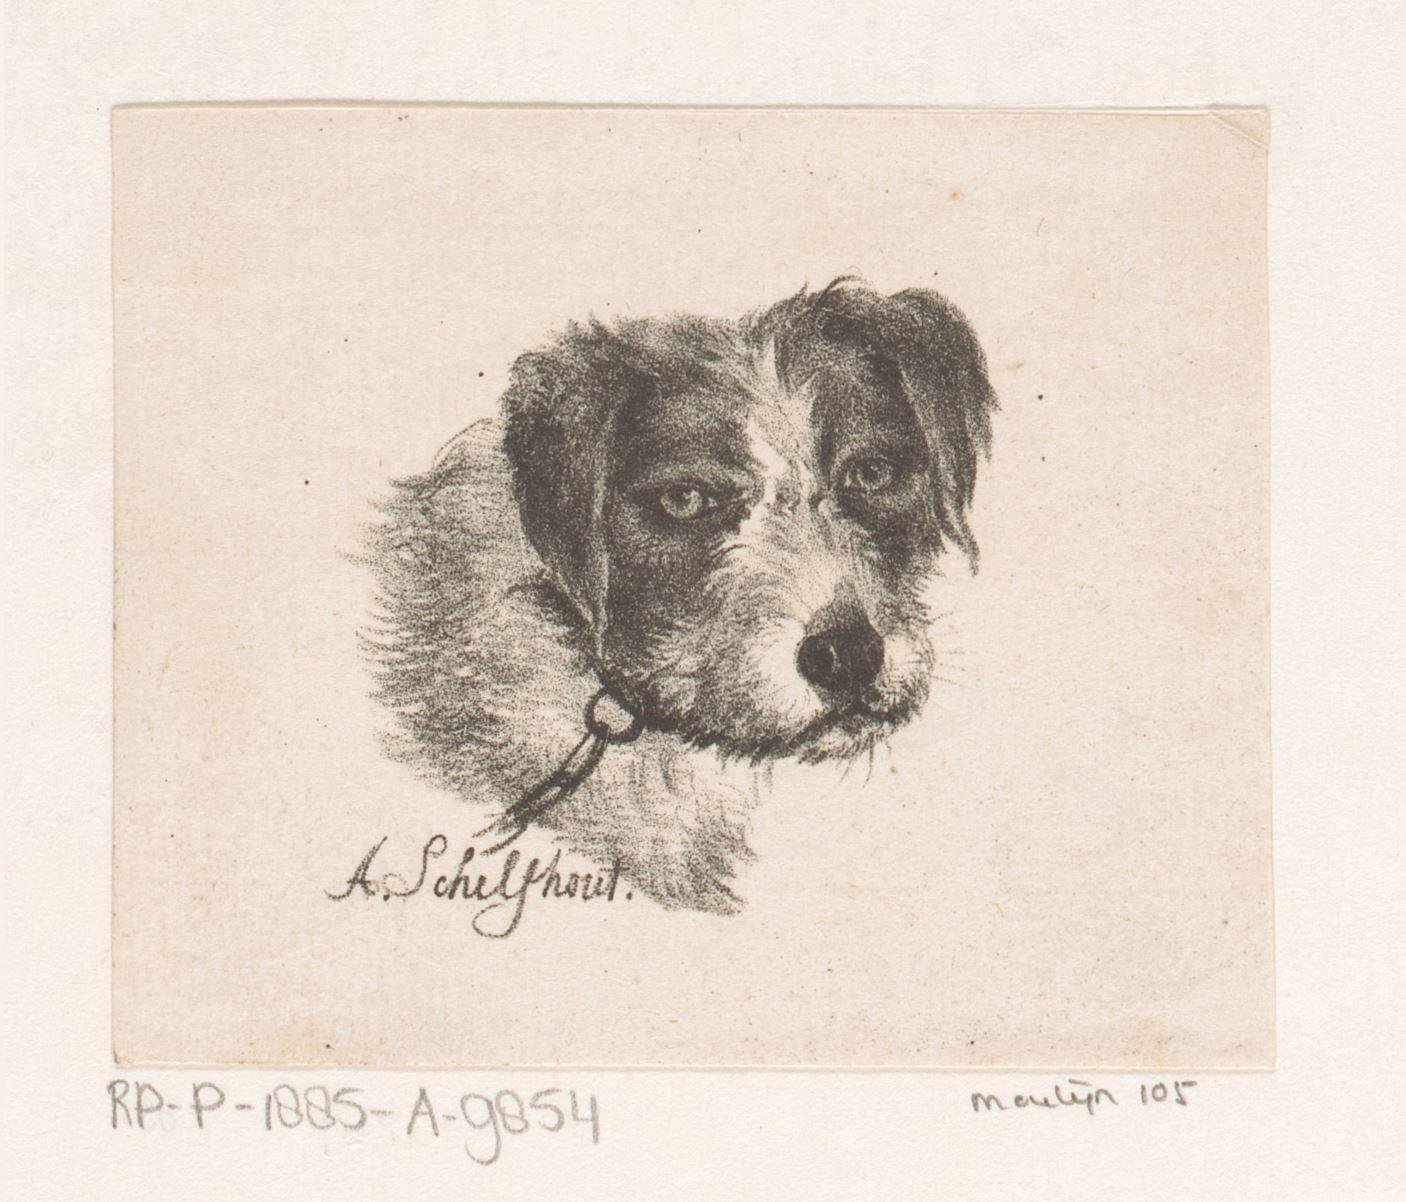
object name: print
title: Hondenkop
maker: andreas schelfhout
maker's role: draughtsman, painter, print maker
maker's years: 1787-1870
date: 1813-1833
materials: paper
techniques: lithograph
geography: the hague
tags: dog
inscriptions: collector's mark: Lugt 2228